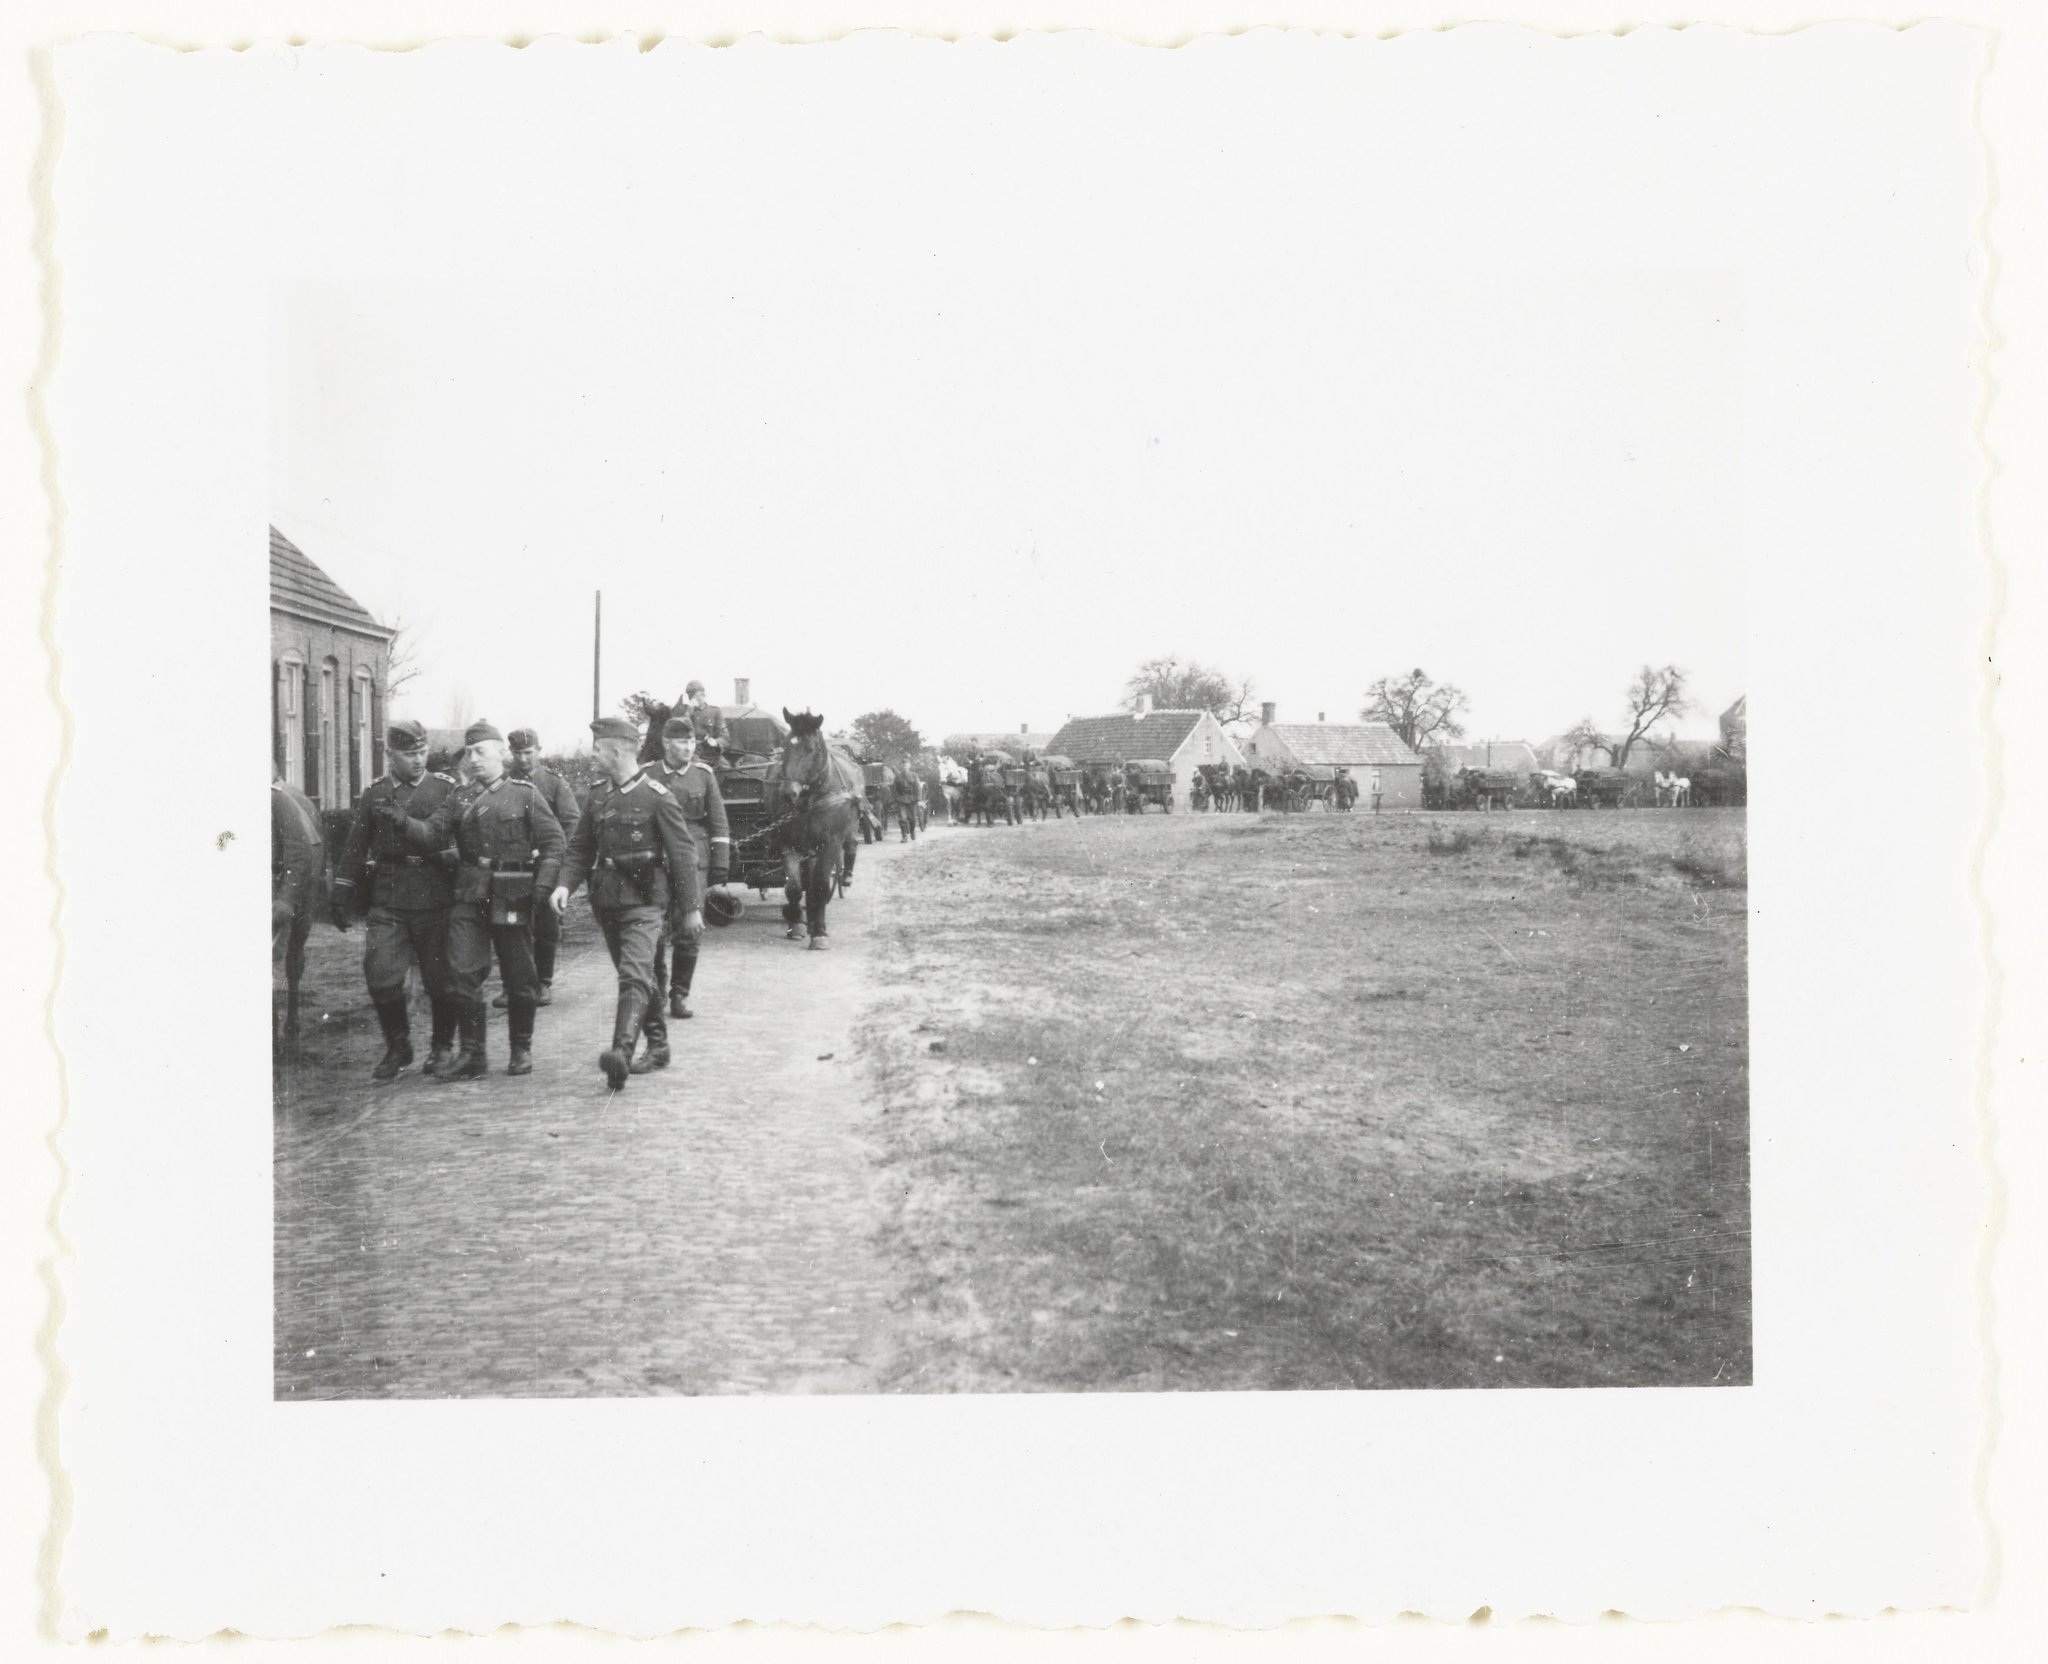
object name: photograph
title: Wehrmacht kompagnie op mars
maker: Anonymous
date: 1904-1941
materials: photographic support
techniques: gelatin silver print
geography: netherlands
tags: army 'en route', occupation ~ war, netherlands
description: Een kompagnie van de Wehrmacht is op mars in een landelijk gebied. Achter een paar manschappen is een lange rij te zien van karren getrokken door paarden. Achterop staat: In Holland. Auf dem Marsch. April 1941.